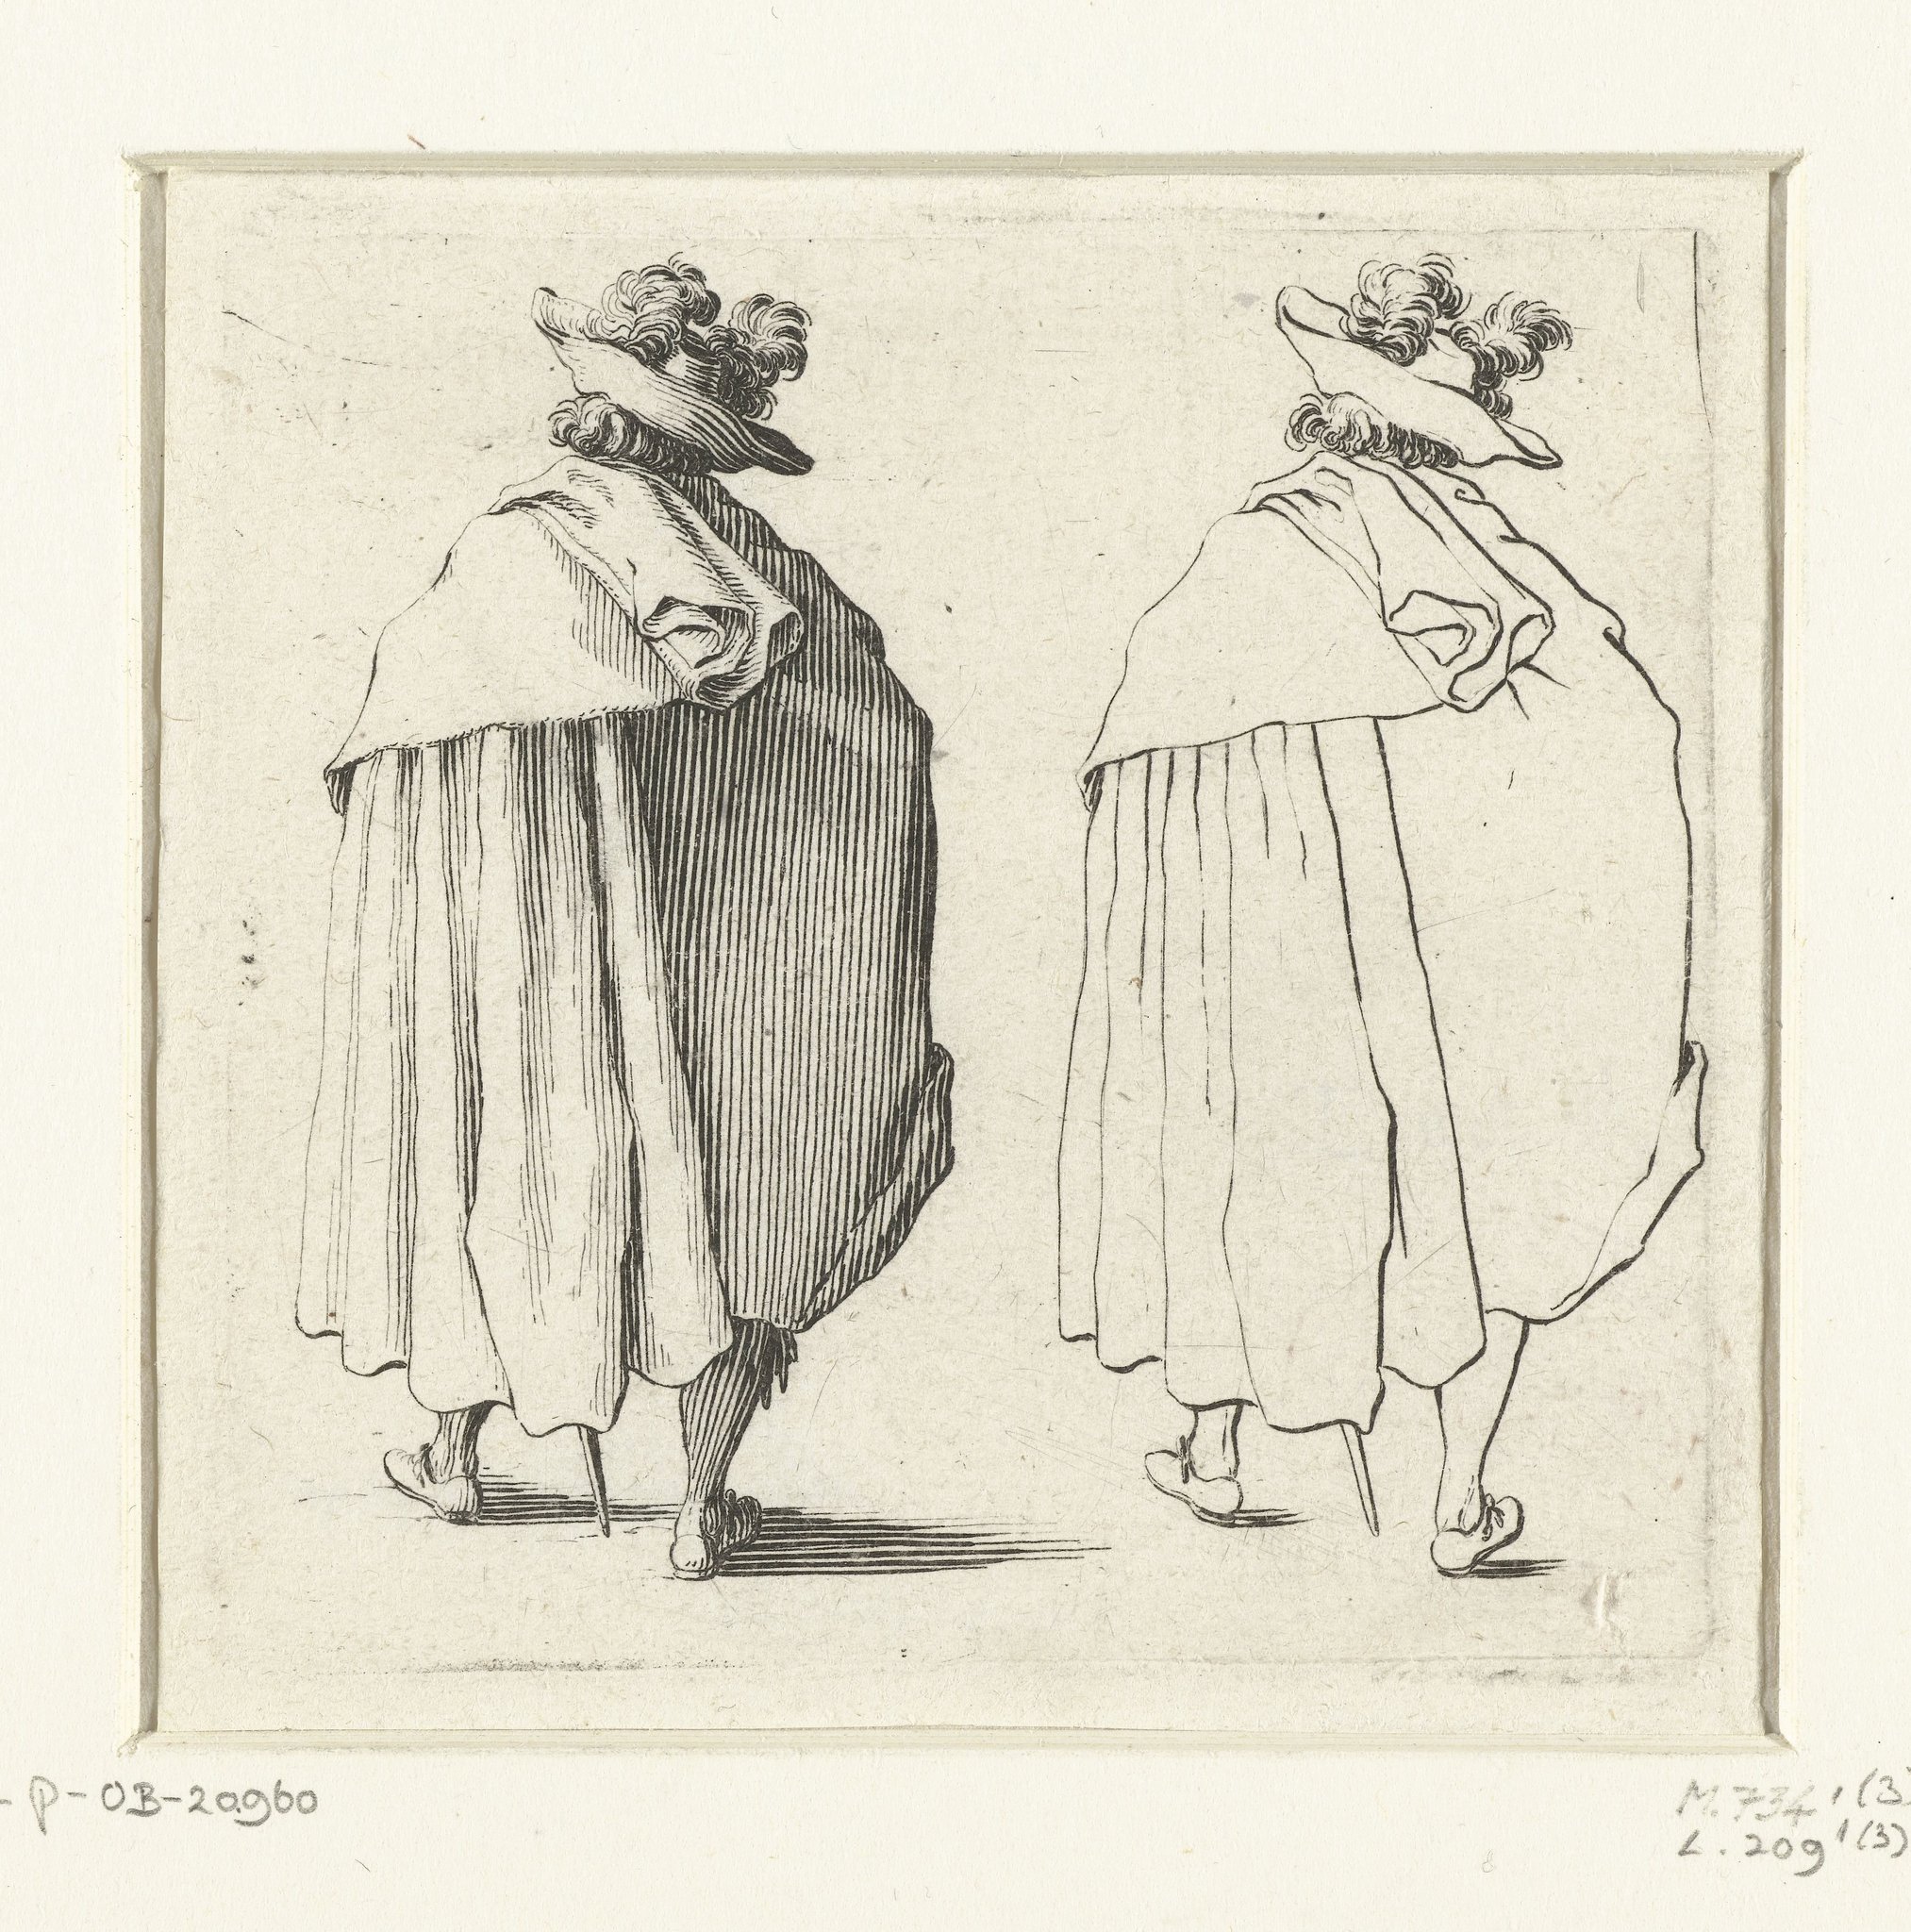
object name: print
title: Varie figure di Jacopo Callot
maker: jacques callot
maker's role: draughtsman, print maker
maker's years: 1592-1635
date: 1621-1624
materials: paper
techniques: etching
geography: nancy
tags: coat (+ men's clothes), head-gear: hat (+ men's clothes)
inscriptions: collector's mark: Lugt 240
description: Een soldaat met een lange mantel aan en een gepluimde hoed op het hoofd, op de rug gezien, tweemaal afgebeeld: rechts als lijnfiguur, links meer uitgewerkt met schaduwpartijen. Deze prent is onderdeel van een serie van 16 prenten (15 volgens Lieure; 17 resp. 16 incl. titelprent) met mannen en vrouwen in diverse houdingen. Mogelijk zijn deze prenten bedoeld geweest als tekenvoorbeelden.